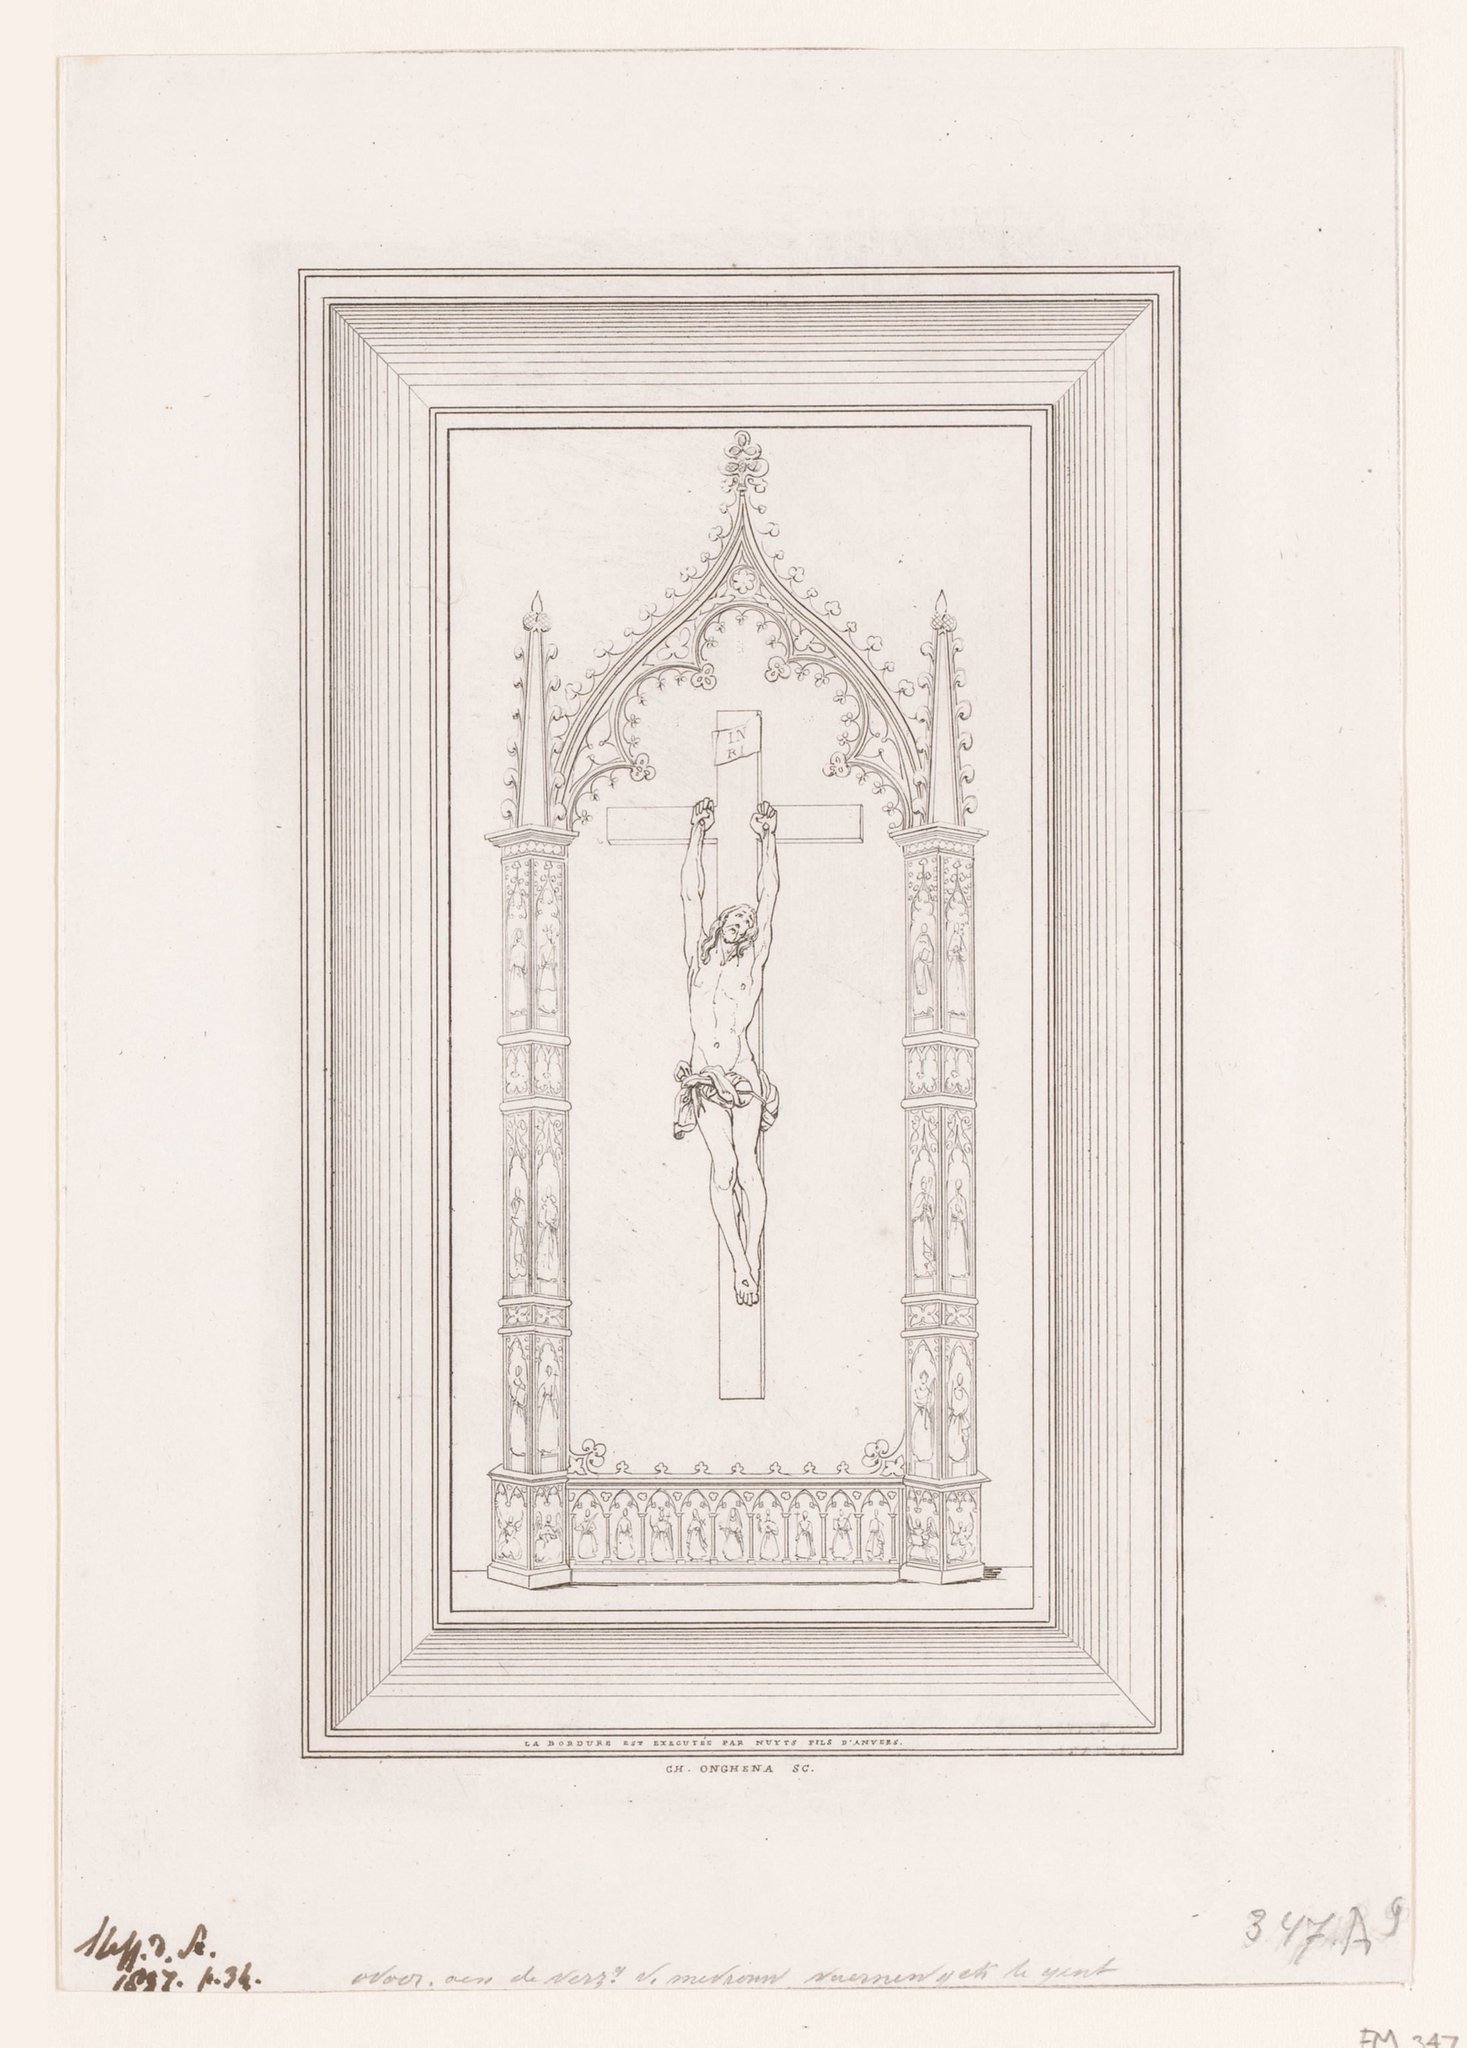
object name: historical object representation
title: Ivoren crucifix in het huis van burggravin Vaernewijck d'Angest in Gent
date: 1837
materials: paper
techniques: etching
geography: ghent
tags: charles v (holy roman emperor and king of spain), crucifix ~ personal devotion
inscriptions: collector's mark: Lugt 2228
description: Prent uit: Reiffenberg, F. de, et al. Messager des sciences et des arts de la Belgique, ou nouvelles archives historiques, littéraires, et scientifiques. Gent: Léonard Hebbelynck, 1837, p. 34.